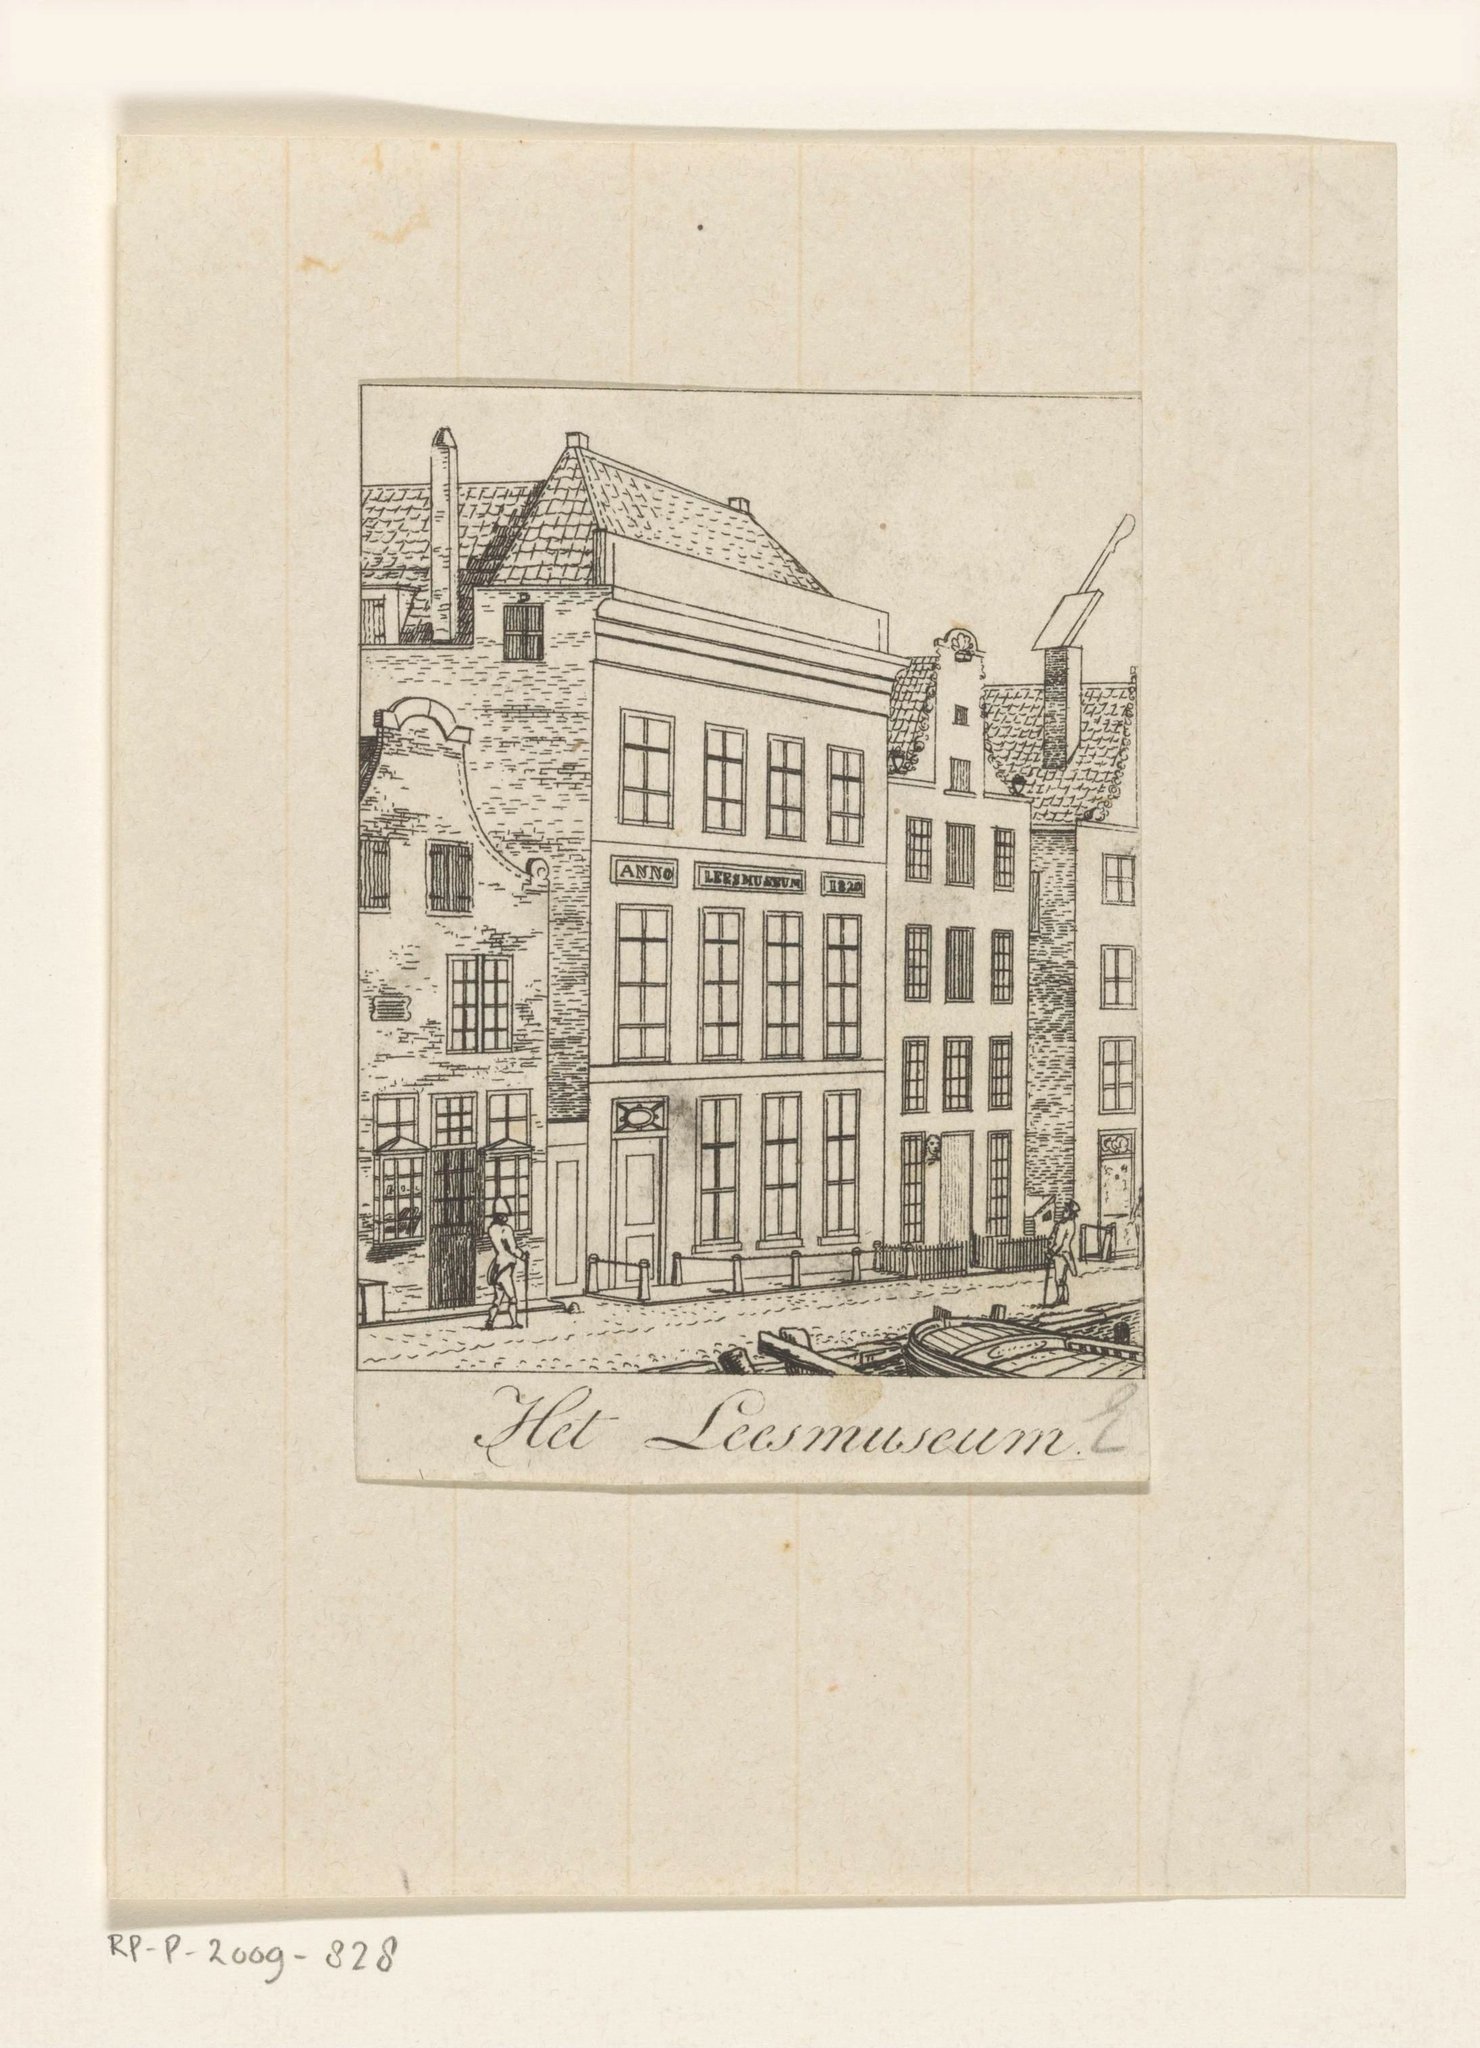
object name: print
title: Het Leesmuseum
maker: Anonymous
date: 1820-1840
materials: paper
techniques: etching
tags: public library